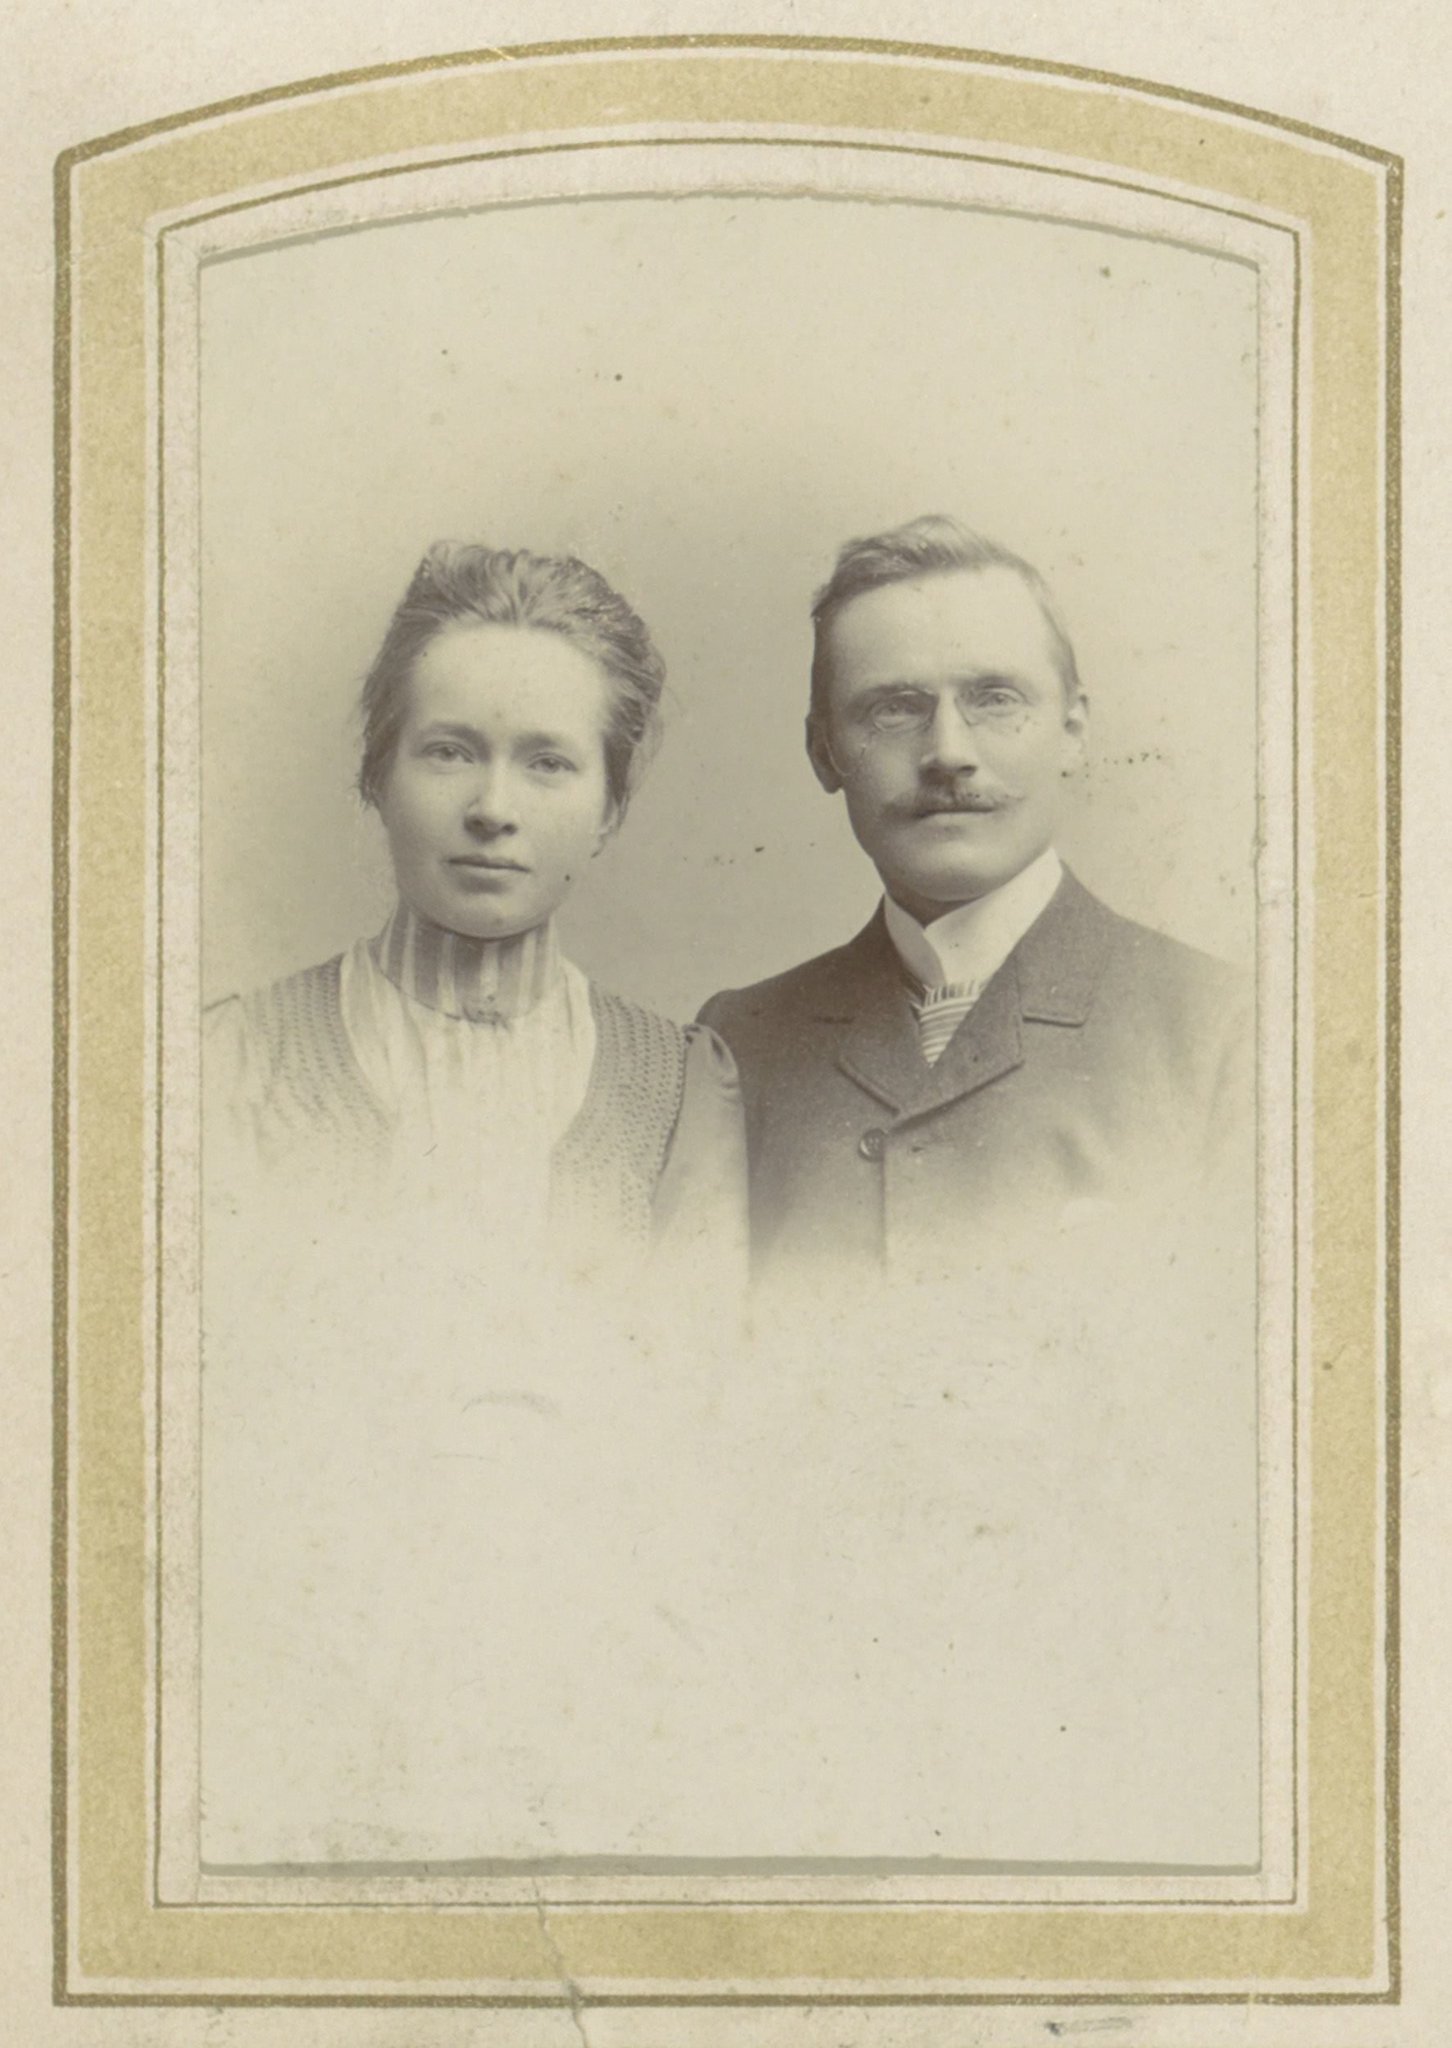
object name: carte de visite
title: Portret van een vrouw en een man met een pince-nez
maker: max büttinghausen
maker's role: fotograaf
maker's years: 1847-1906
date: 1873-1895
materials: cardboard, paper, photographic support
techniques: daylight paper print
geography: netherlands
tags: eyeglasses, spectacles, historical persons, styles of hairdress - aa - ~ women, neck-gear ~ clothing, clothing for the upper part of the body, netherlands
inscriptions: number: ‘15’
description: Onderdeel van Fotoalbum van een Nederlandse familie met 168 cartes-de-visite en kabinetfoto's.